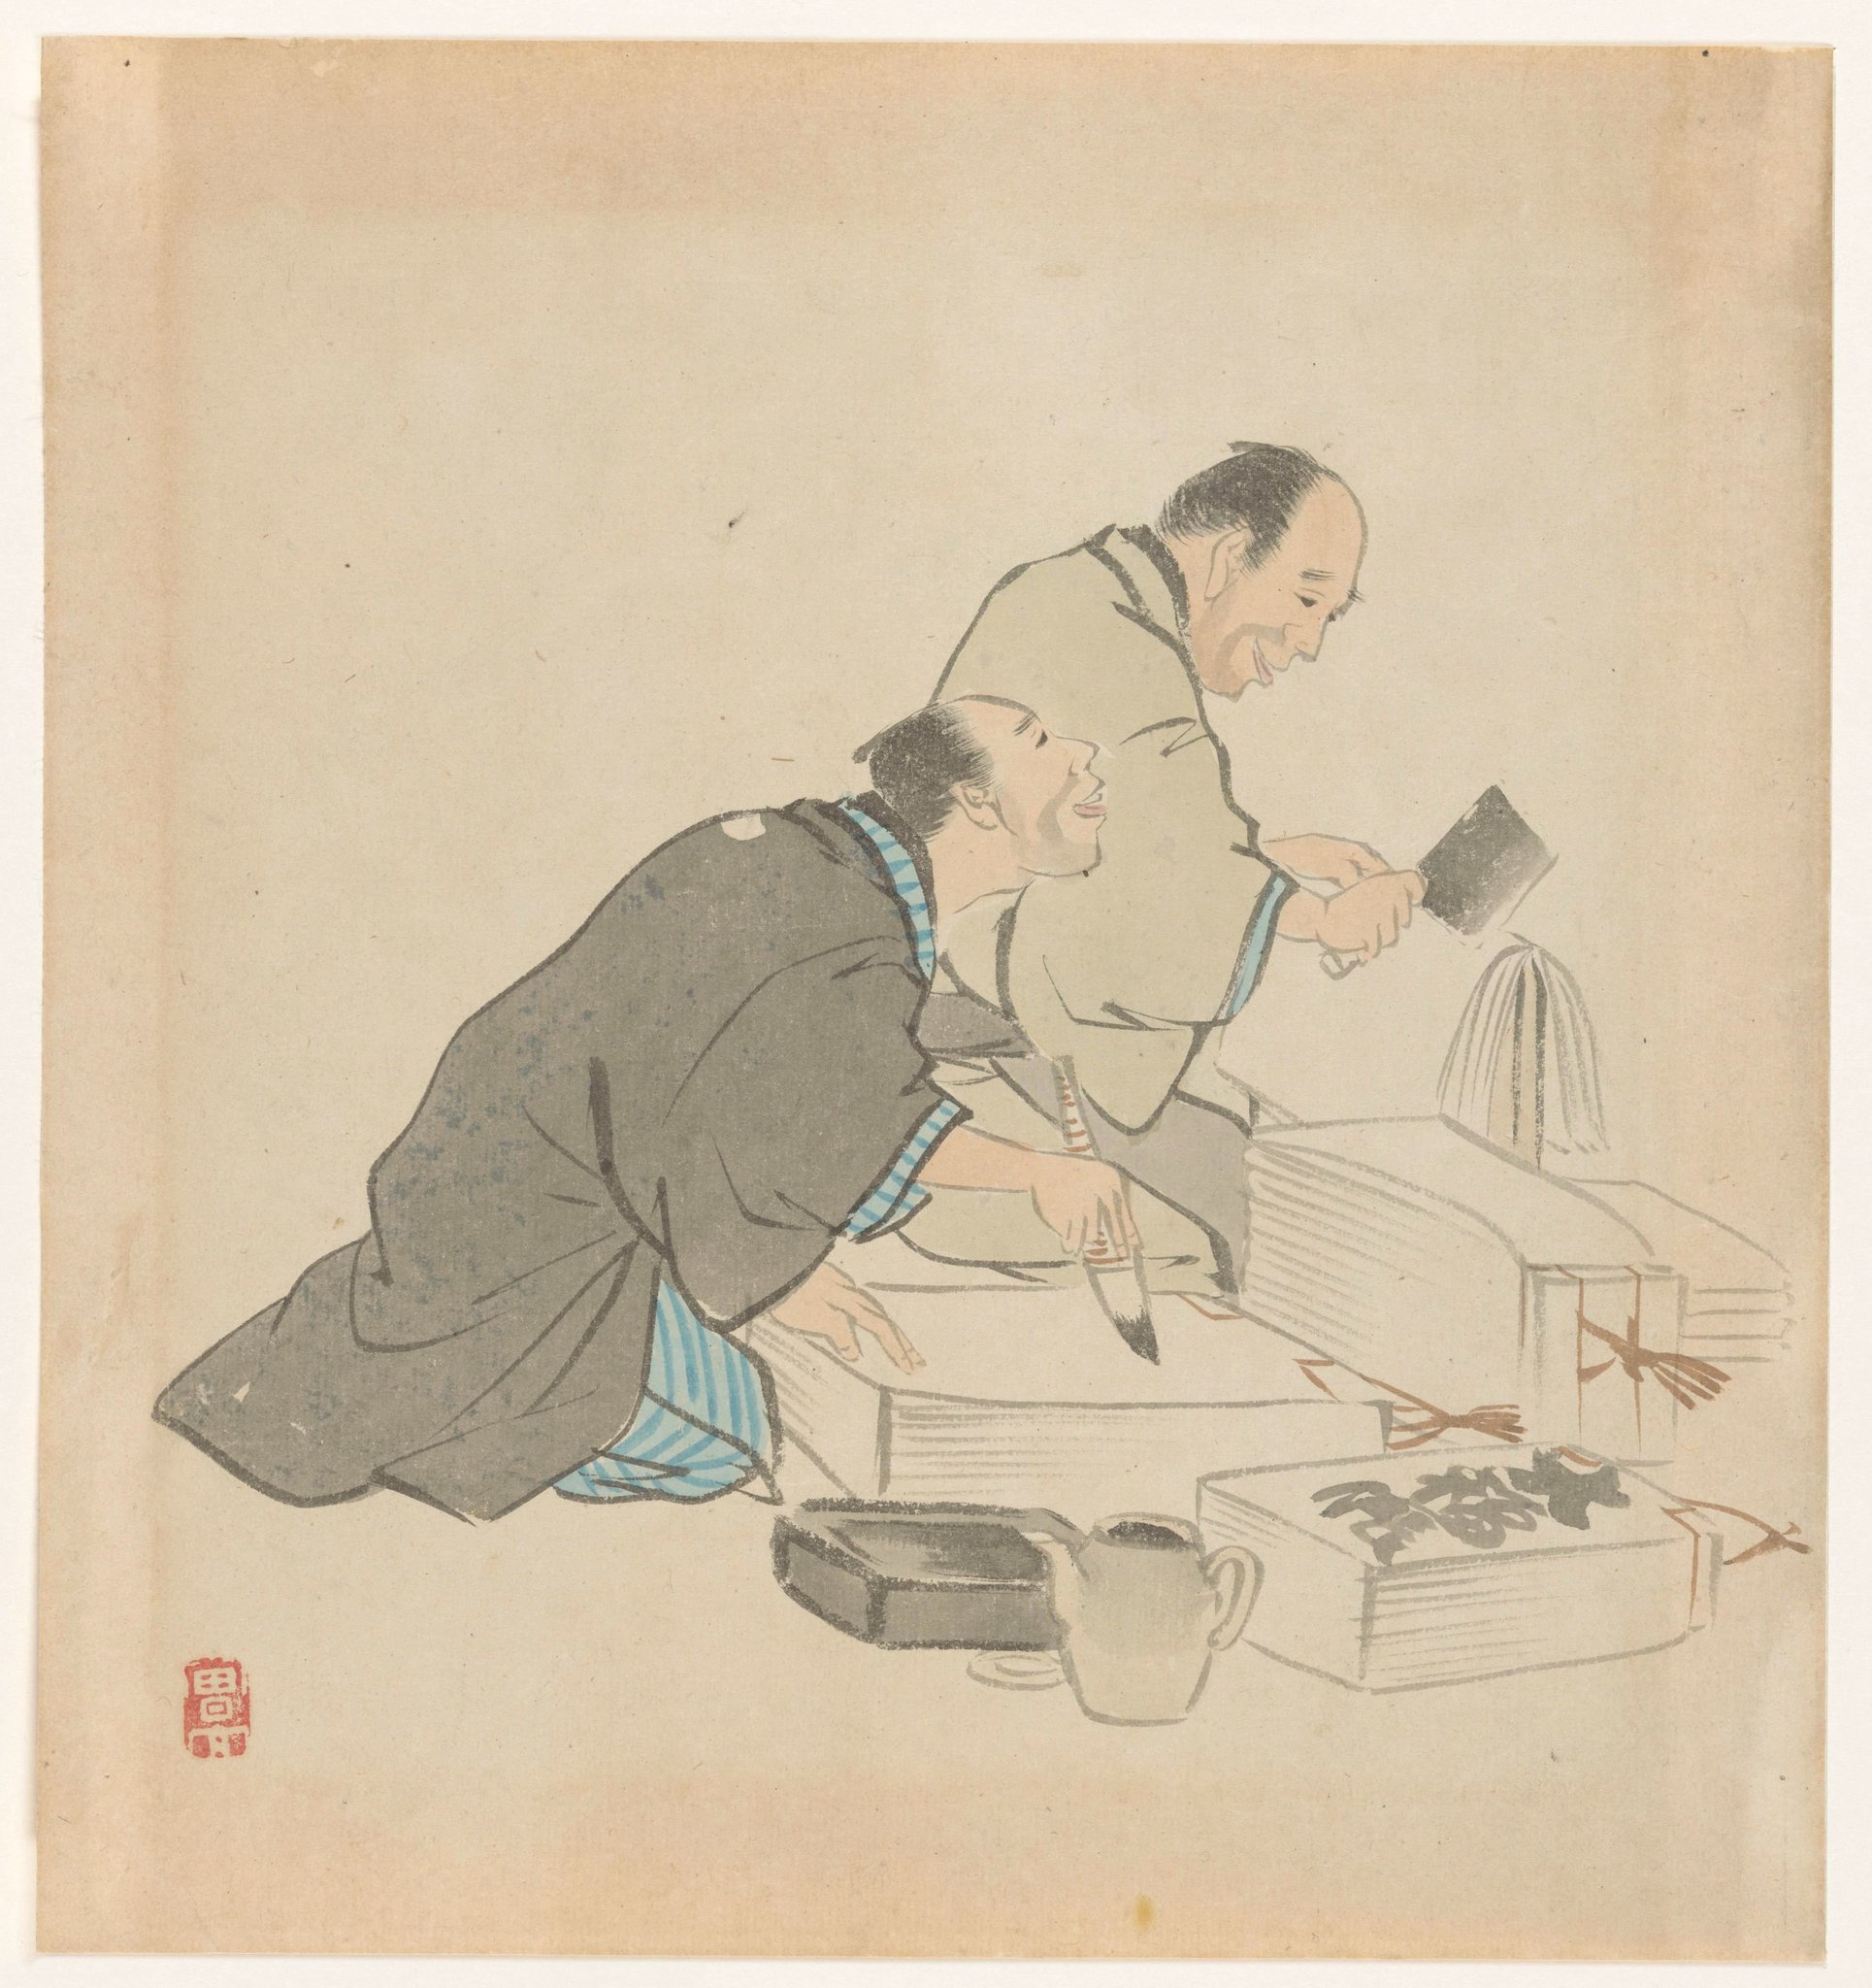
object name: drawing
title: Japanse kalligraaf en een Japanse boekbinder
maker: Anonymous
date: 1900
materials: paper, watercolor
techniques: brush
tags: bookbinding, japanese, calligraphy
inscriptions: collector's mark: Lugt 2228